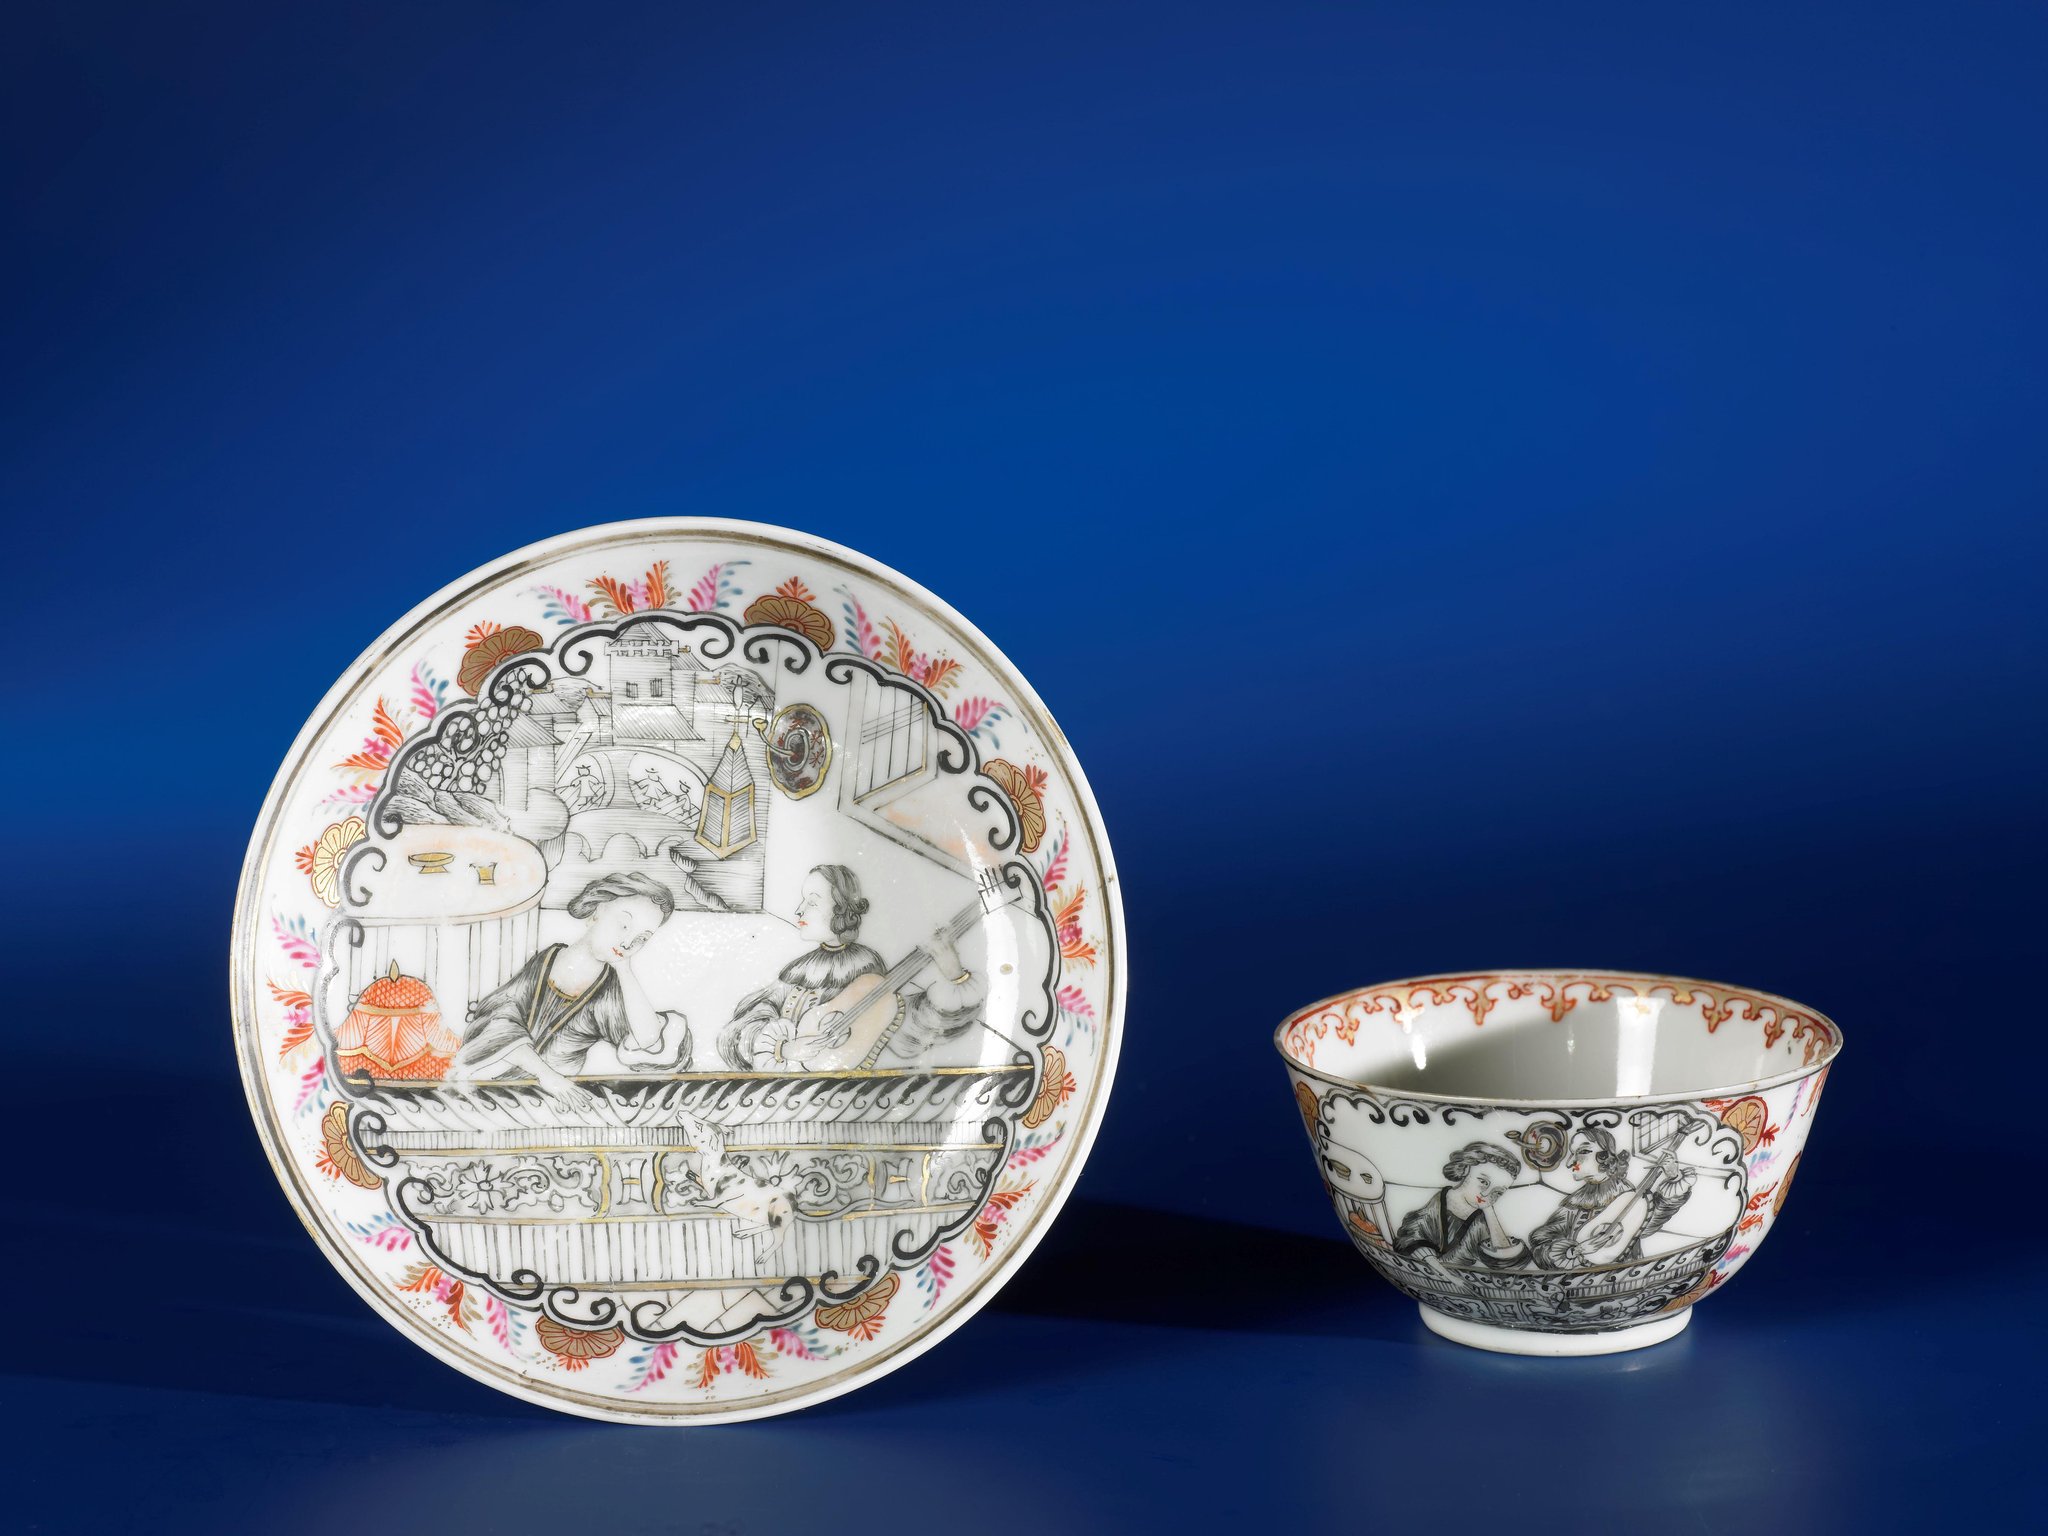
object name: cup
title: Bell-shaped cup with a woman an a man with a mandolin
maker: Anonymous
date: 1760-1780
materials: glaze, gold, paint, porcelain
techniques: firing, gilding, turning, vitrification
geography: china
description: Wijd uitlopende kop op een hoge voetring en schotel op een voetring. Gedecoreerd in encre de Chine, goud en emailkleuren. Centraal een Europese dame en heer in een interieur. De heer bespeelt een muziekinstrument, de dame kijkt naar een hondje op de voorgrond. Op de achtergrond een doorkijkje naar een kasteel. Rondom op de rand zijn ornamenten geschilderd.